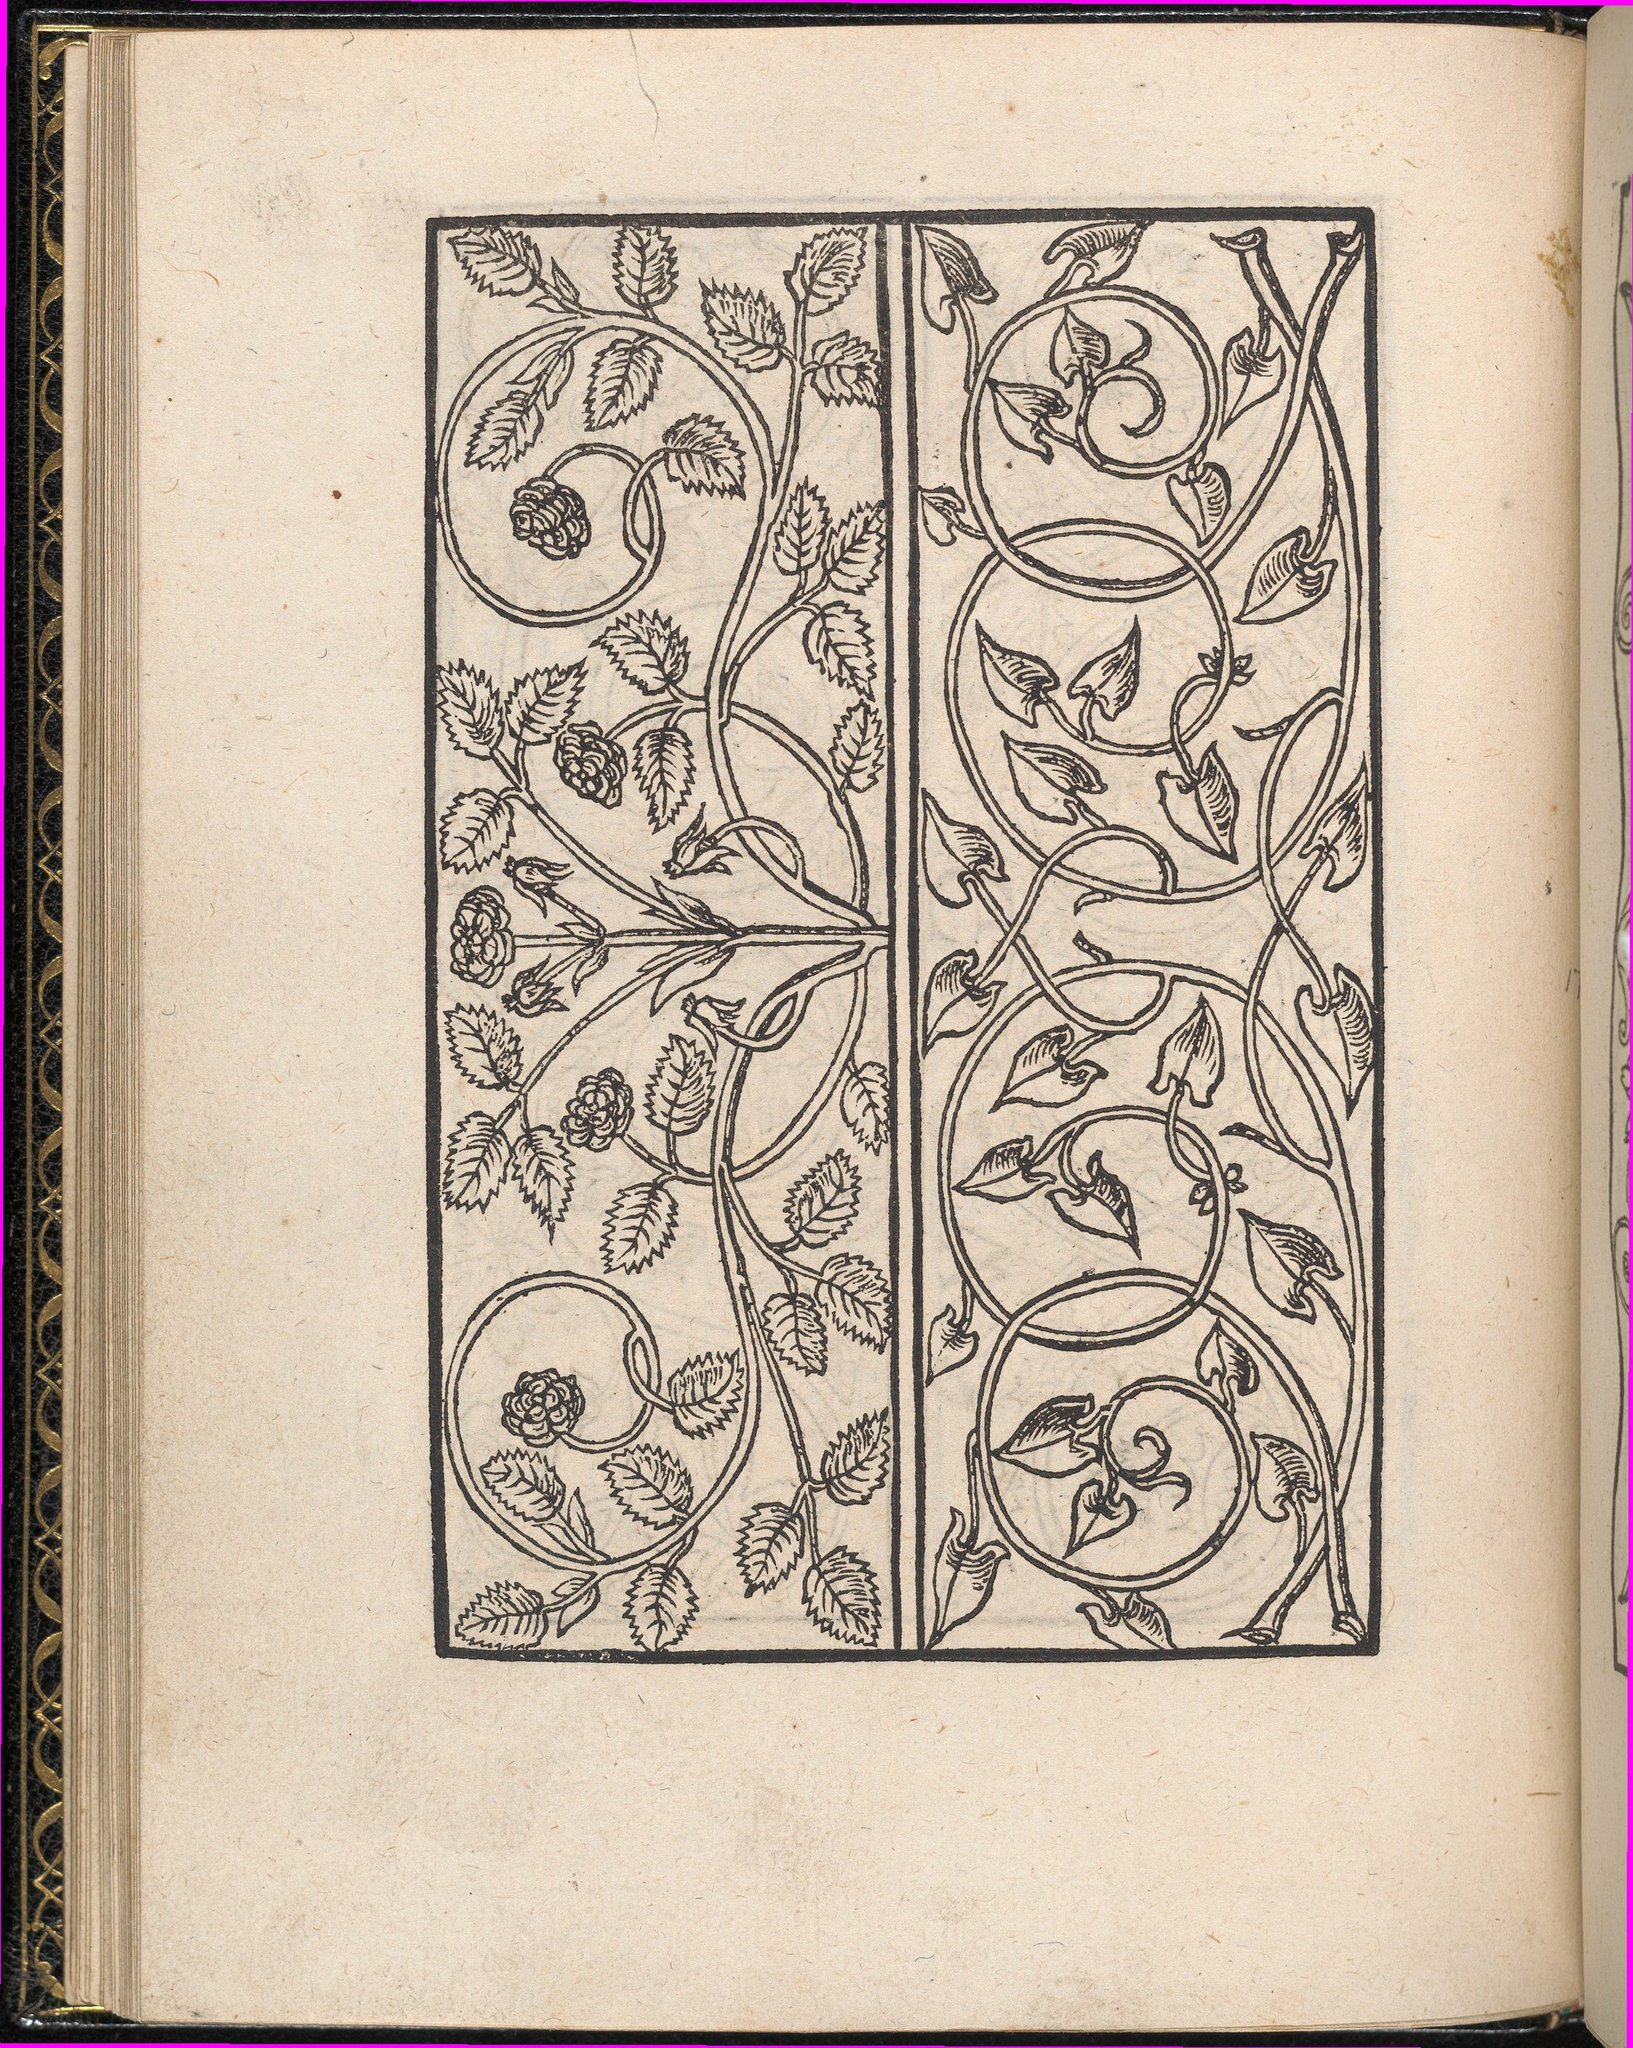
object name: book print ornament architecture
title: Page from Ein new kunstlich Modelbuch...(Page 17v)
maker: peter quentel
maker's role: publisher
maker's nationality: german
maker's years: 1500-1550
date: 1544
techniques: woodcut